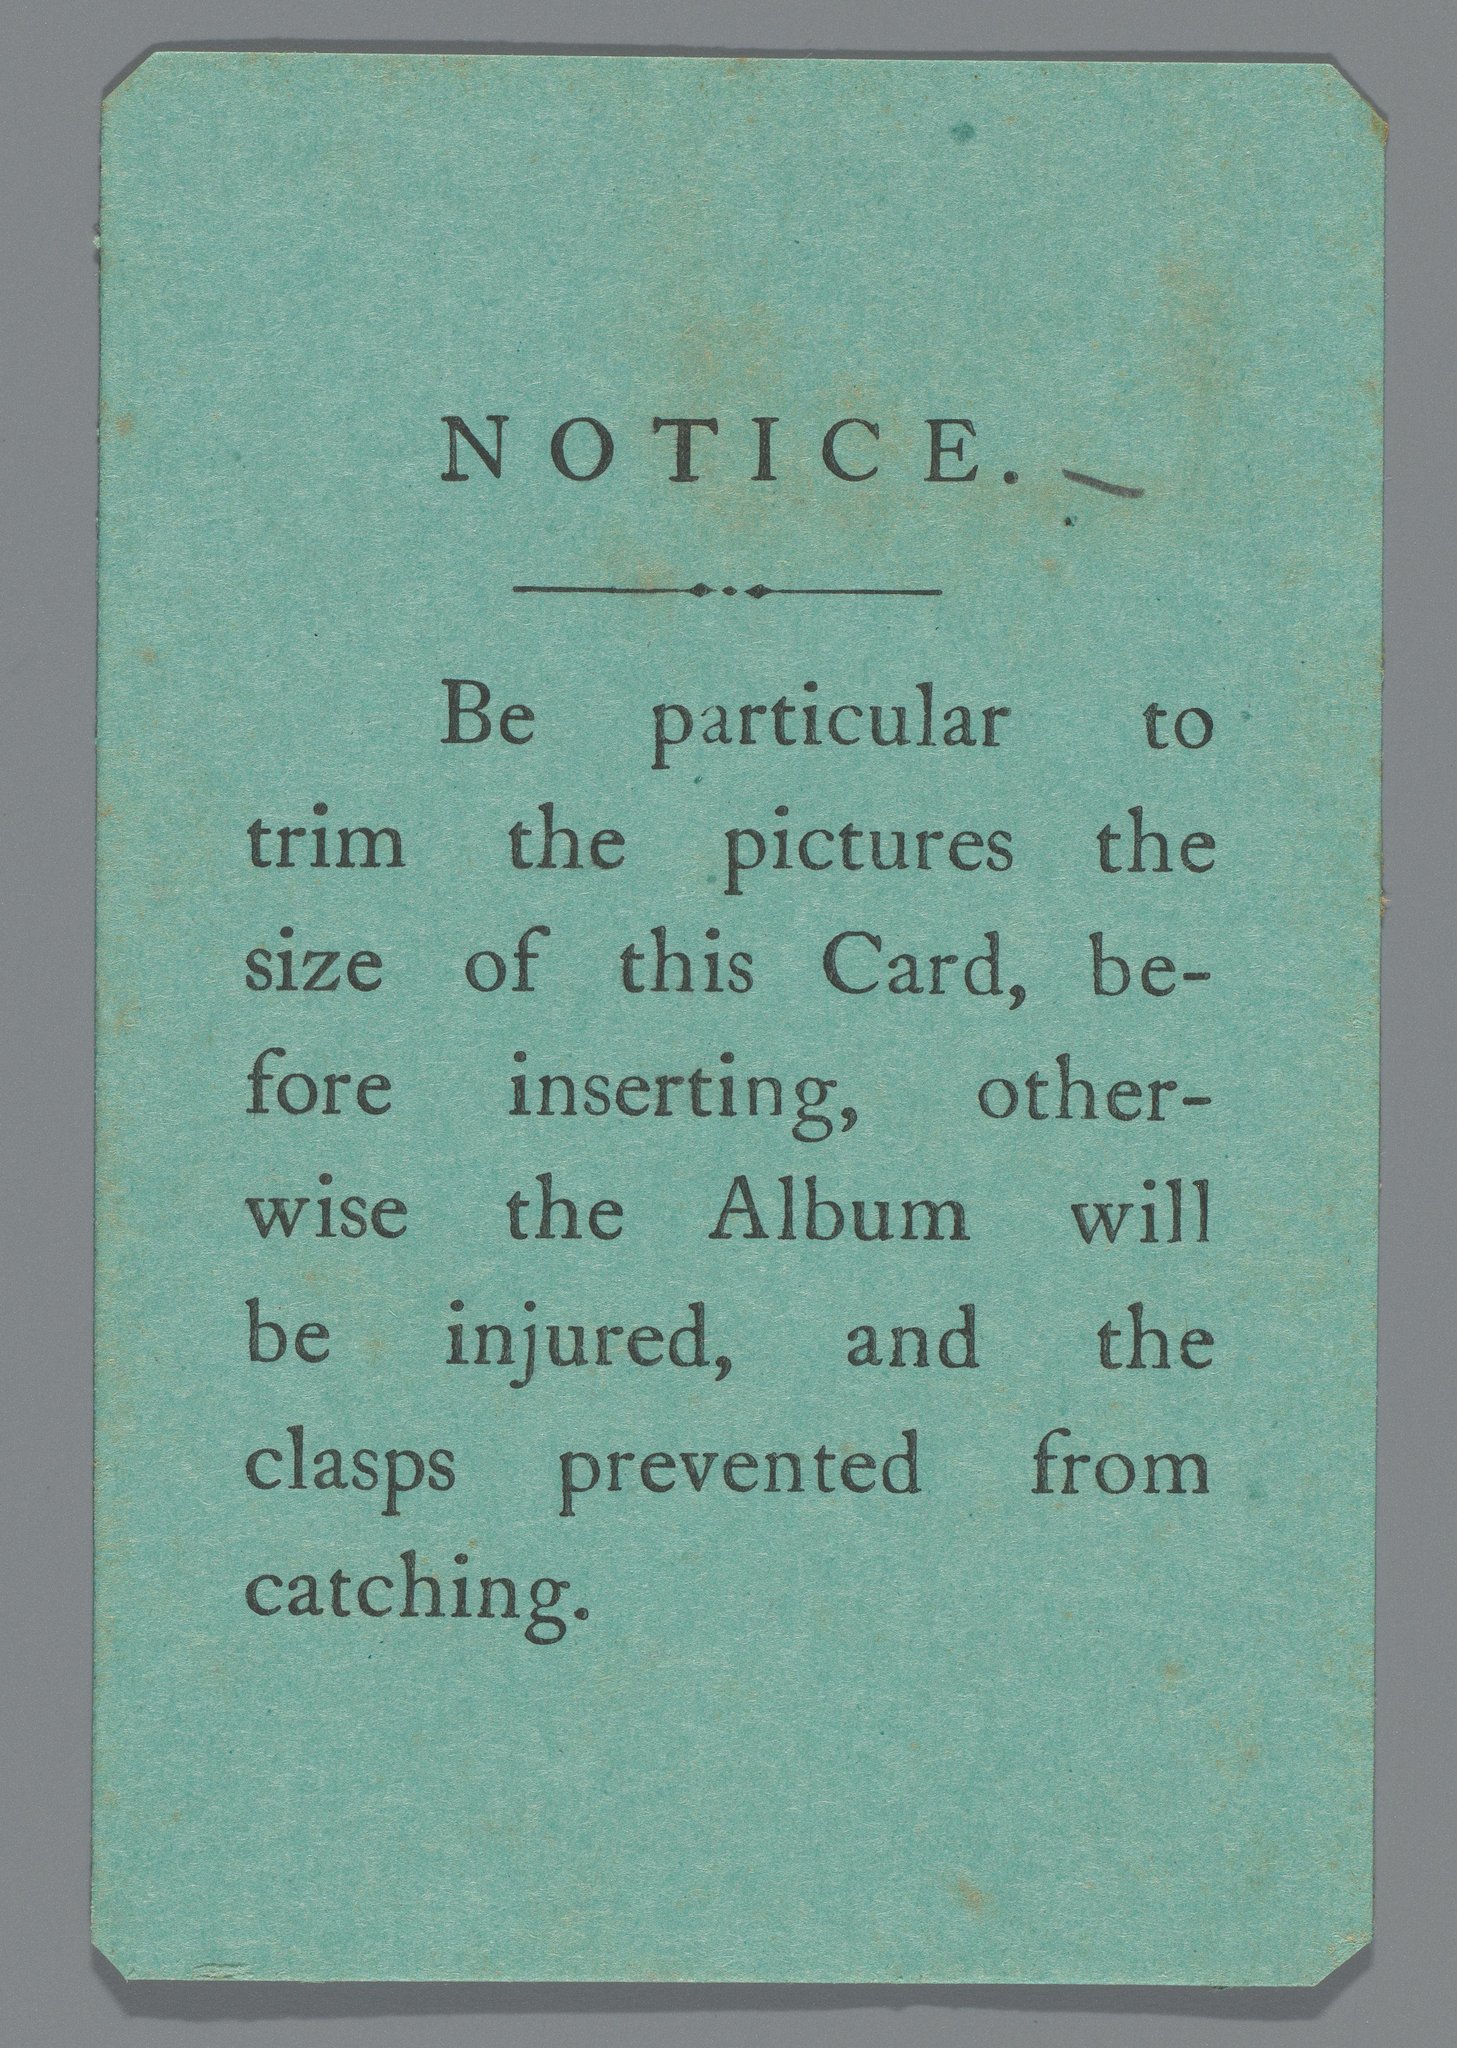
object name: photograph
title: Notice. Be particular to trim pictures the size of this card....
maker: Anonymous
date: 1860-1920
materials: paper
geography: united states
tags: united states of america